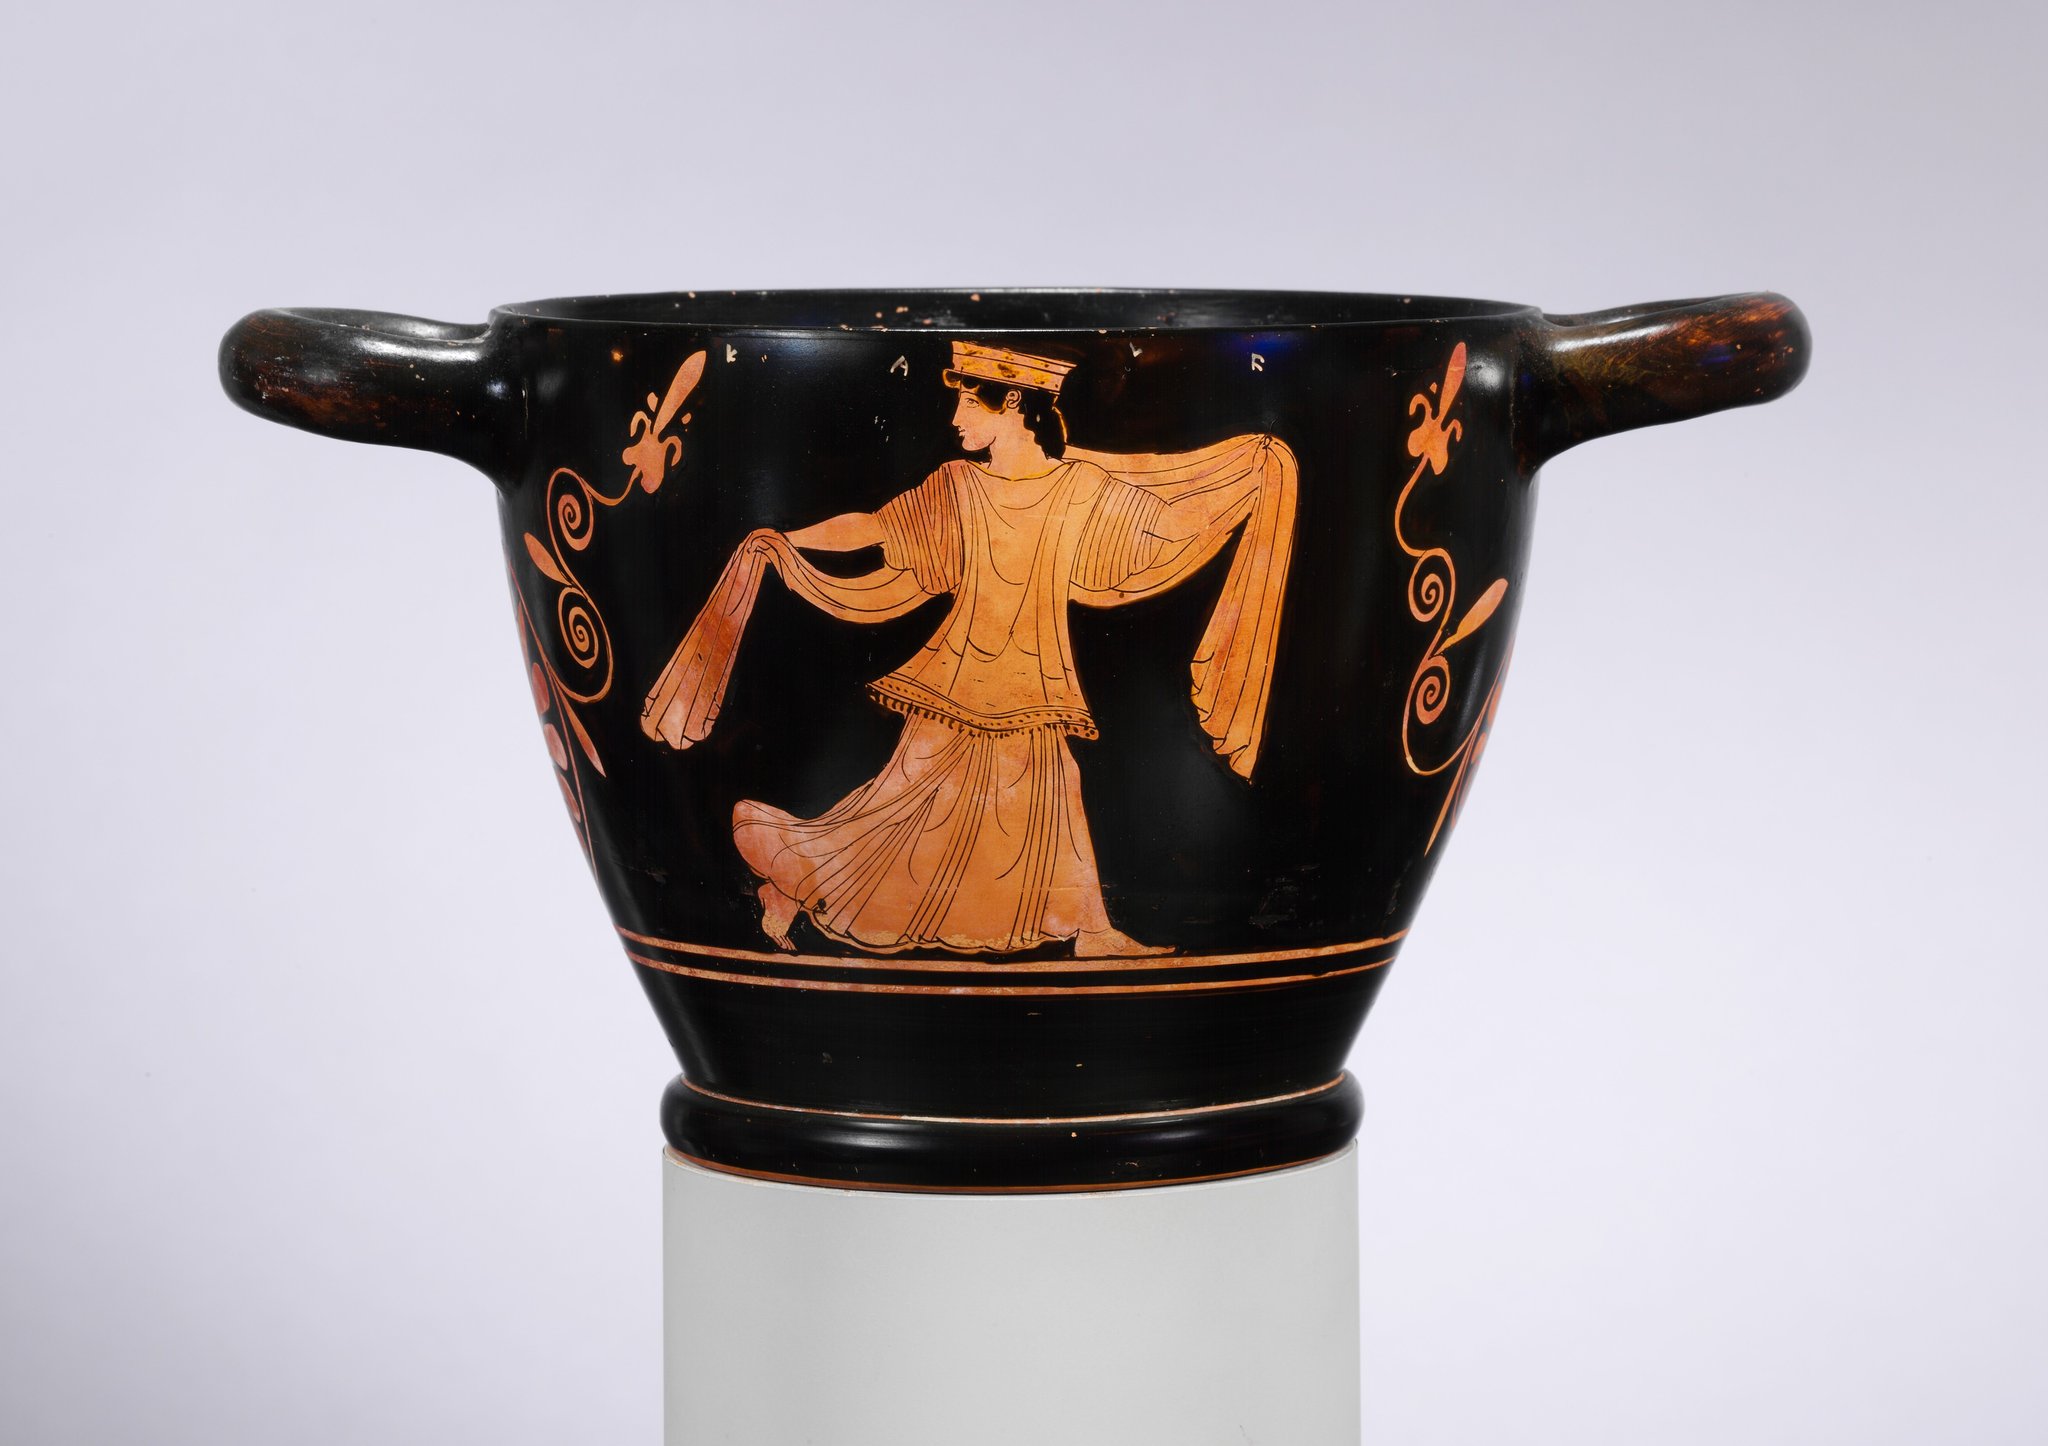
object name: skyphos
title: Terracotta skyphos (deep drinking cup)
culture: greek, attic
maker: lewis painter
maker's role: artist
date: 470 BCE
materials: terracotta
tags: dionysus